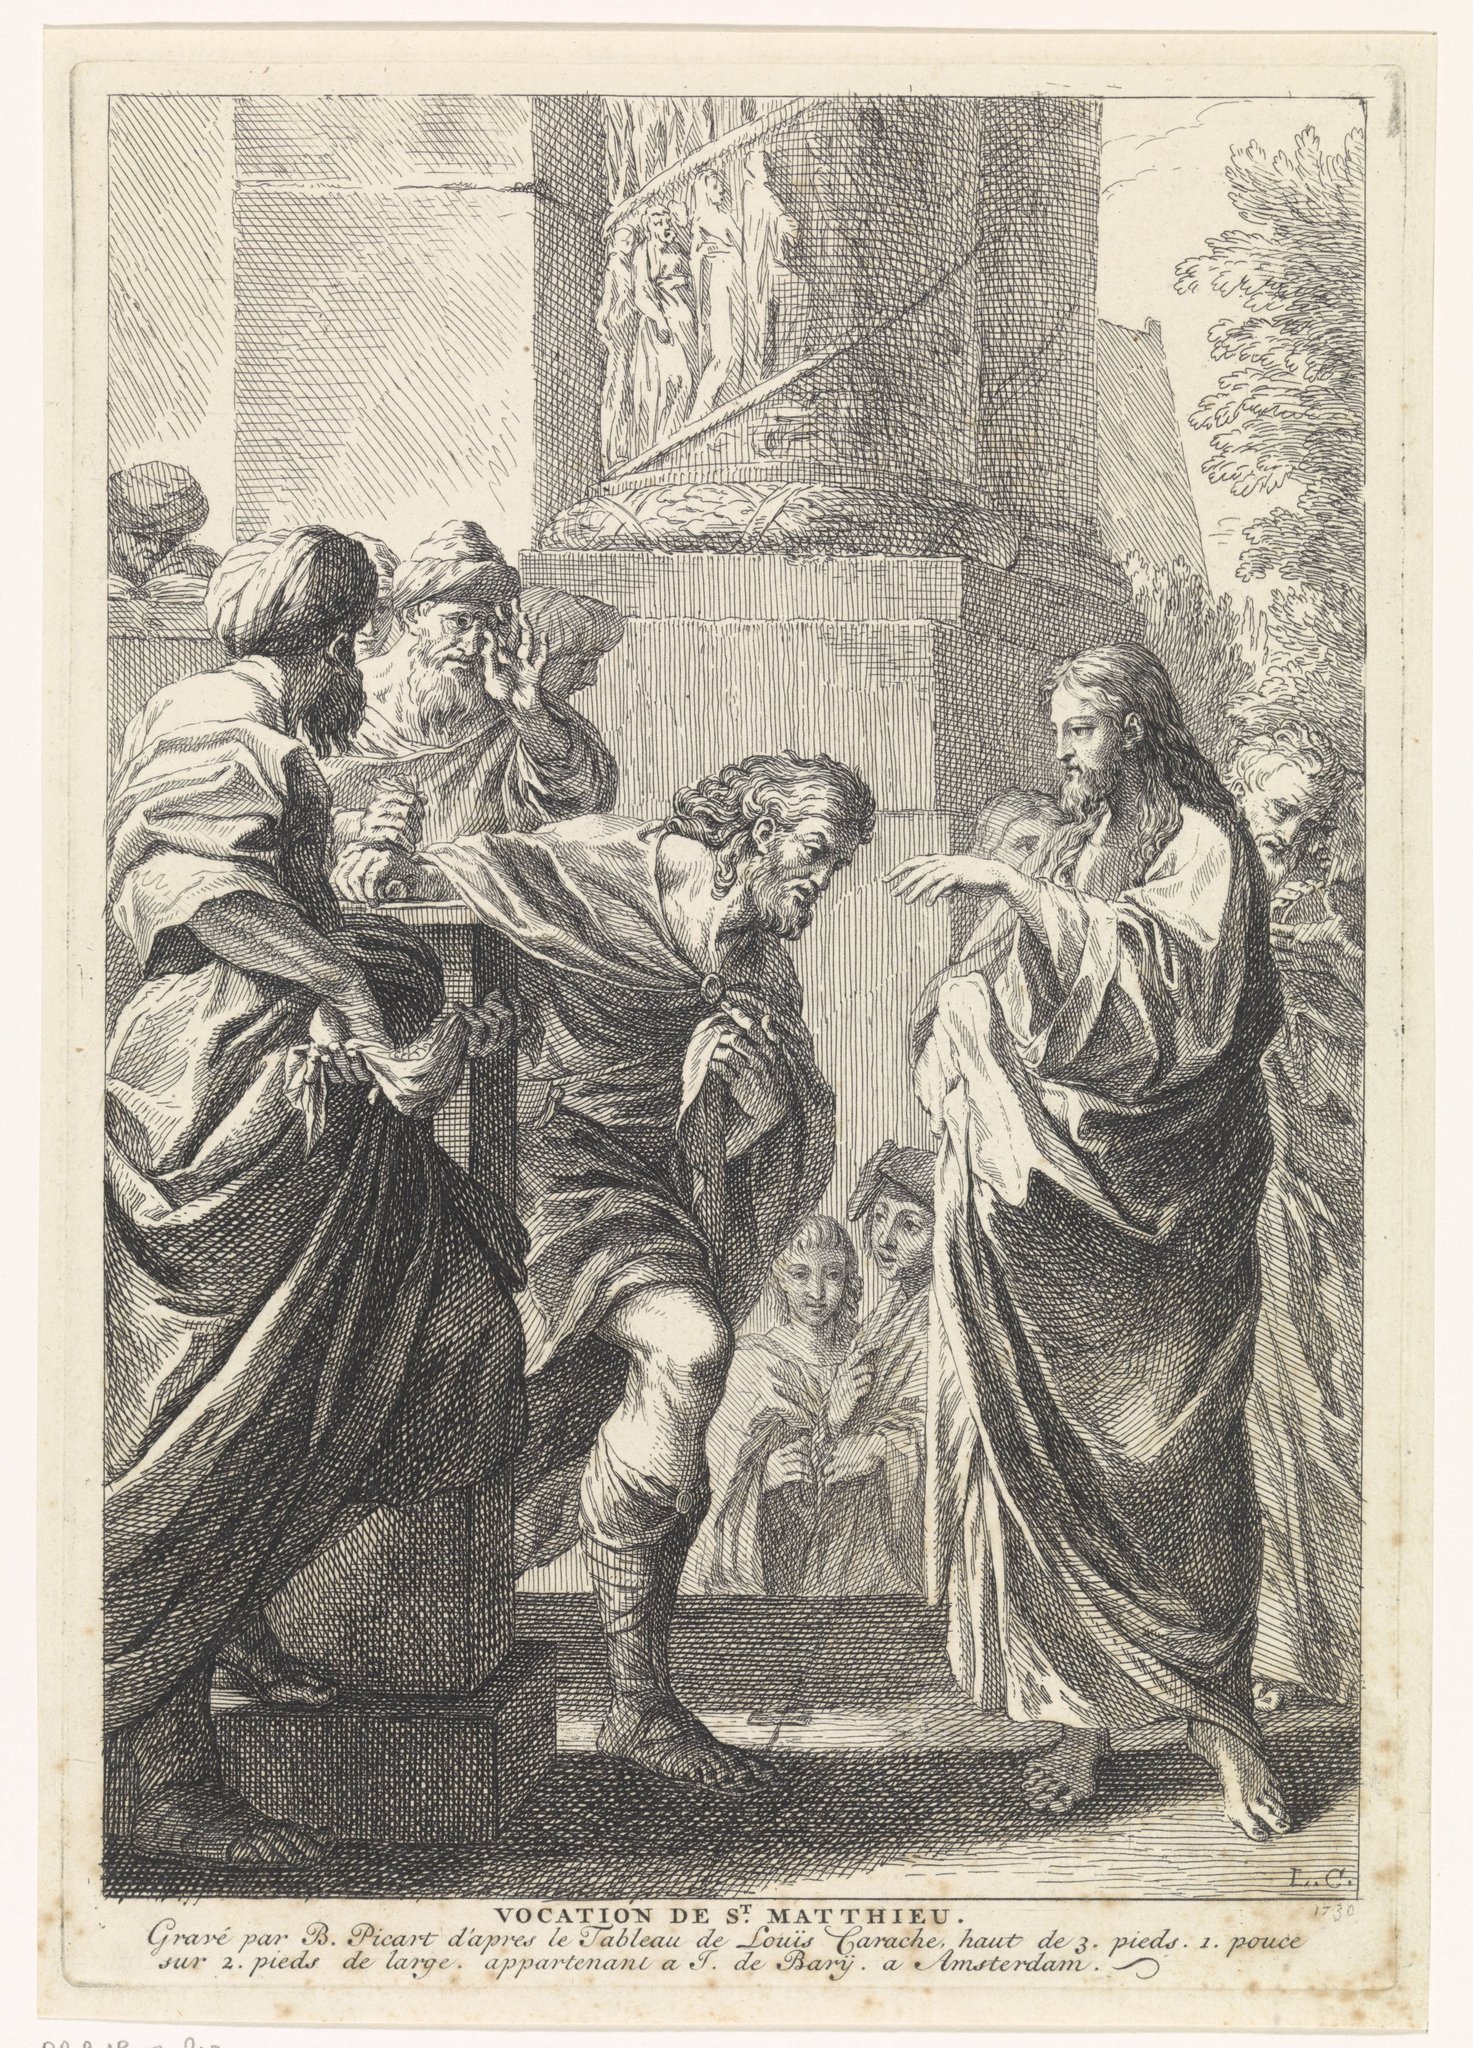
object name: print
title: Roeping van Matteüs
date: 1730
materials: paper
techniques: etching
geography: amsterdam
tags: calling of matthew (levi), the tax-collector (usually with money lying on the table and people paying taxes) (matthew 9:9; mark 2:14; luke 5:27-28)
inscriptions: collector's mark: Lugt 240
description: Definitieve genummerde staat van deze prent opgenomen in: Impostures innocentes, ou recueil d'estampes d'apres divers peintres (...) par Bernard Picart (...) avec son elogue historique et le catalogue de ses ouvrages. Amsterdam: weduwe Bernard Picart, 1734.